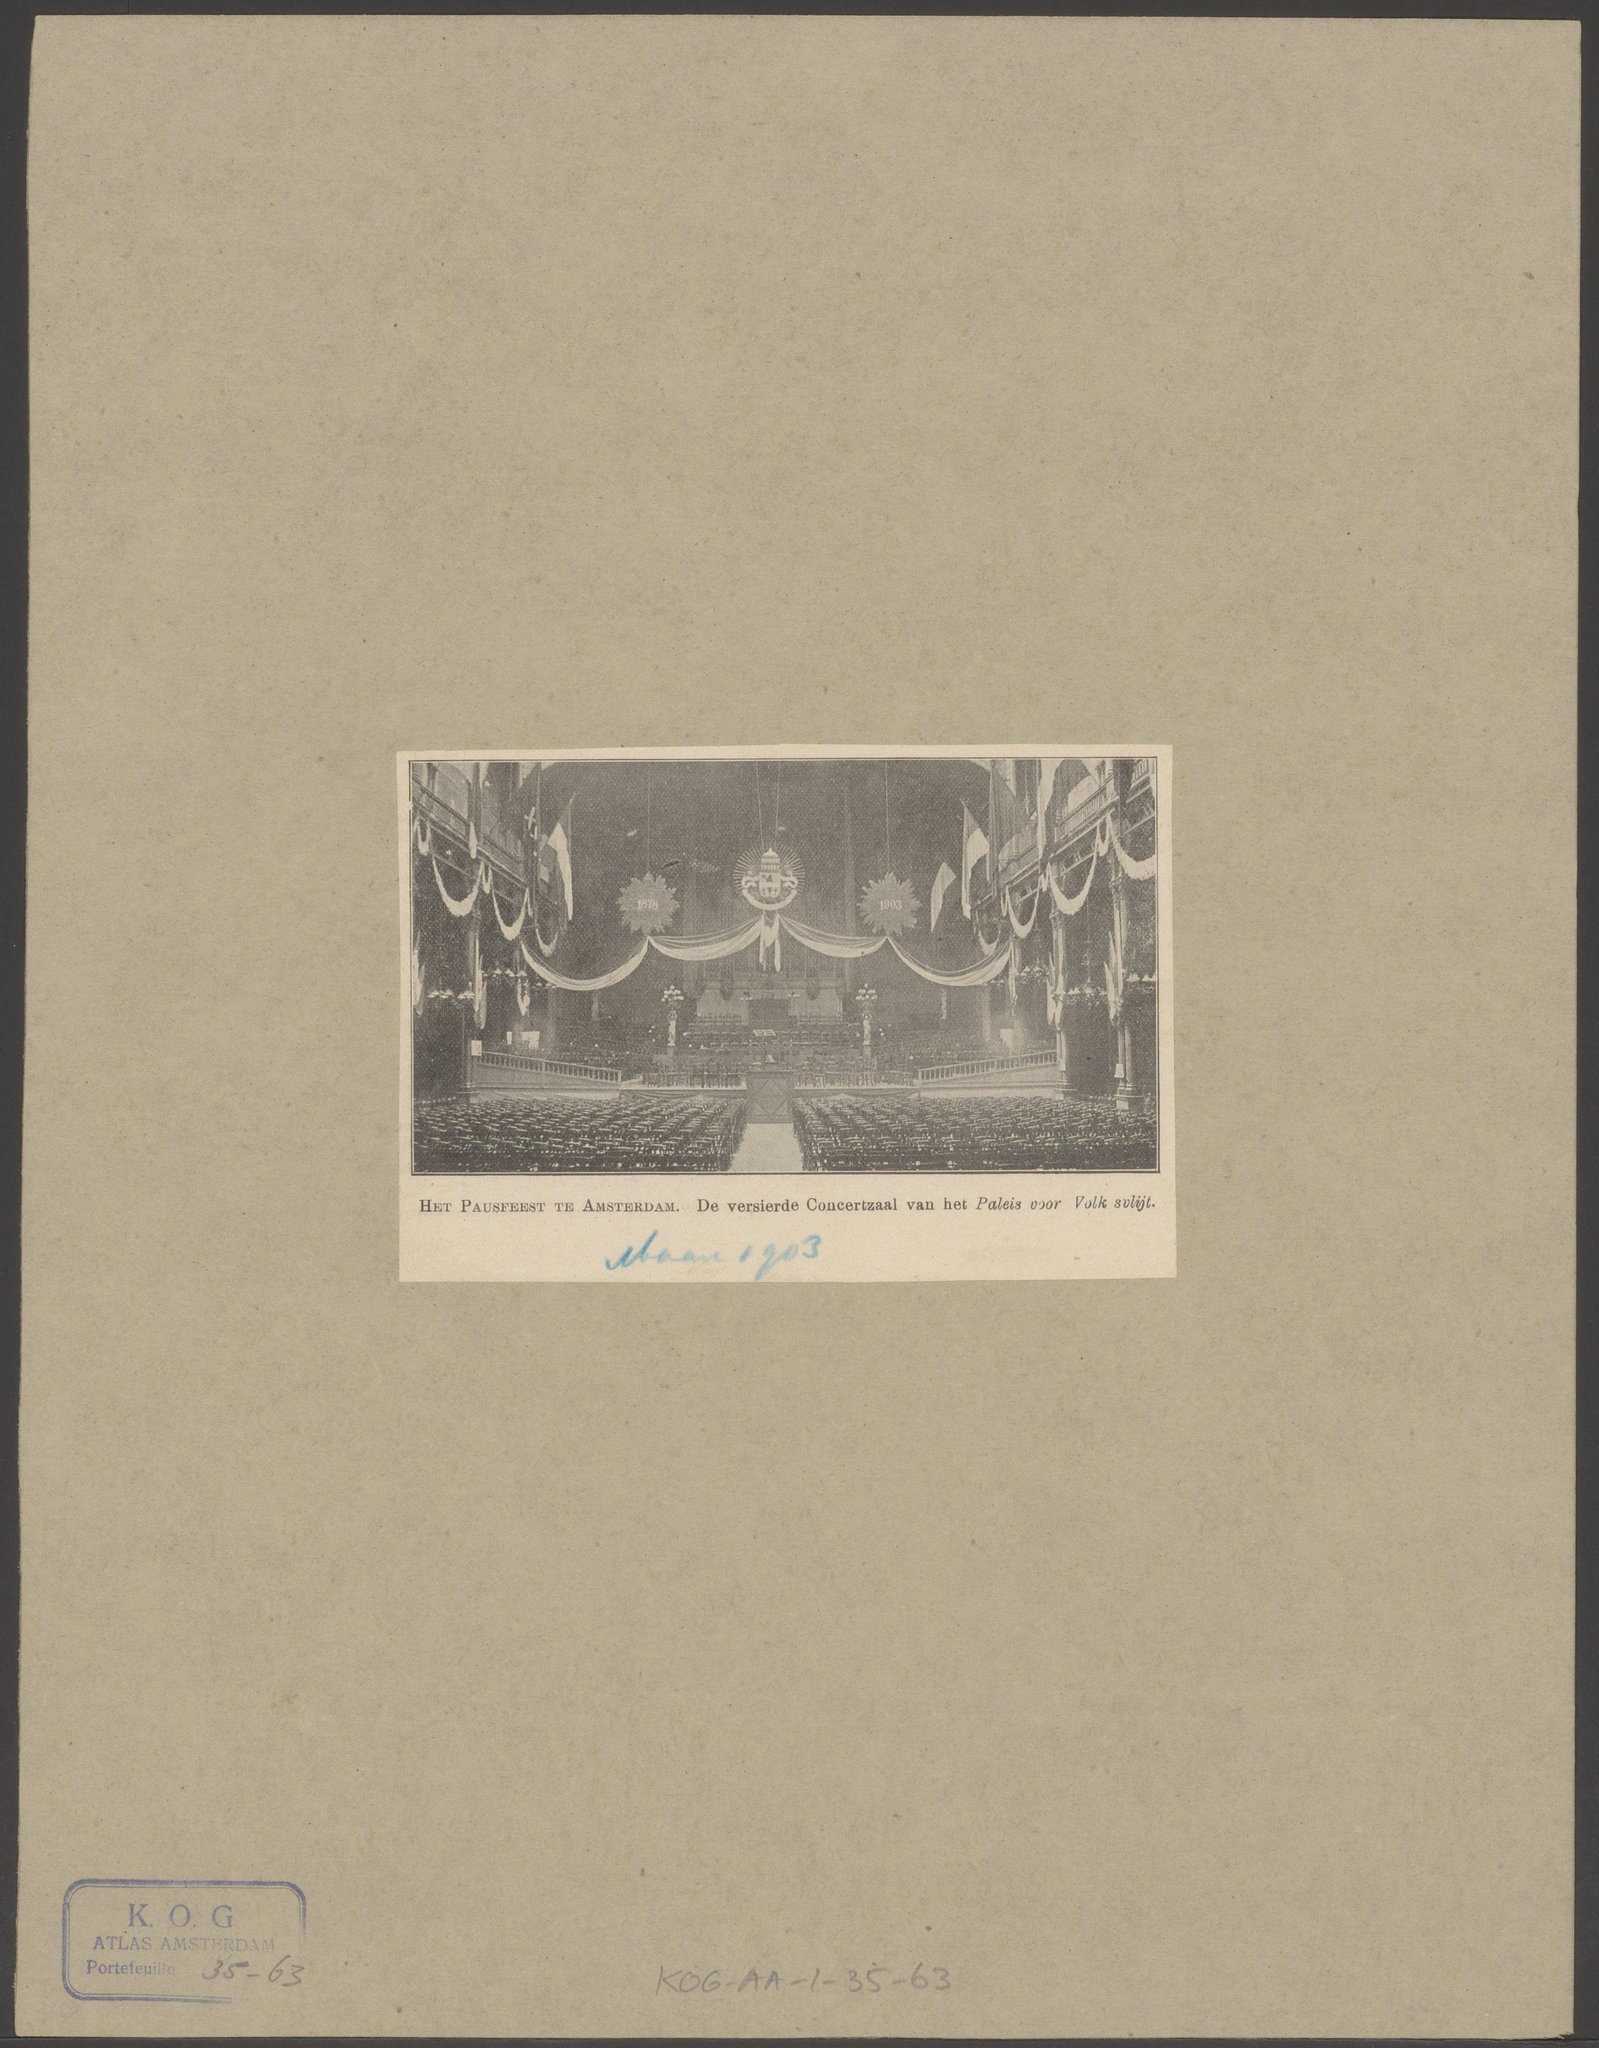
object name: photomechanical print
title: Gezicht op de concertzaal van het Paleis voor Volksvlijt te Amsterdam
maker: Anonymous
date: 1903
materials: paper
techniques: letterpress printing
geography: amsterdam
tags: concert hall, ceremonial celebrations ~ pope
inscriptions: collector's mark: ‘35-63’ Lugt 1641b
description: Ter gelegenheid van het zilveren Pausfeest van Paus Leo XIII. Onderwerpsrubriek binnen de Atlas Amsterdam: R.K. Gemeenten: R.K. feesten / Nederlandse Zouavenbond.